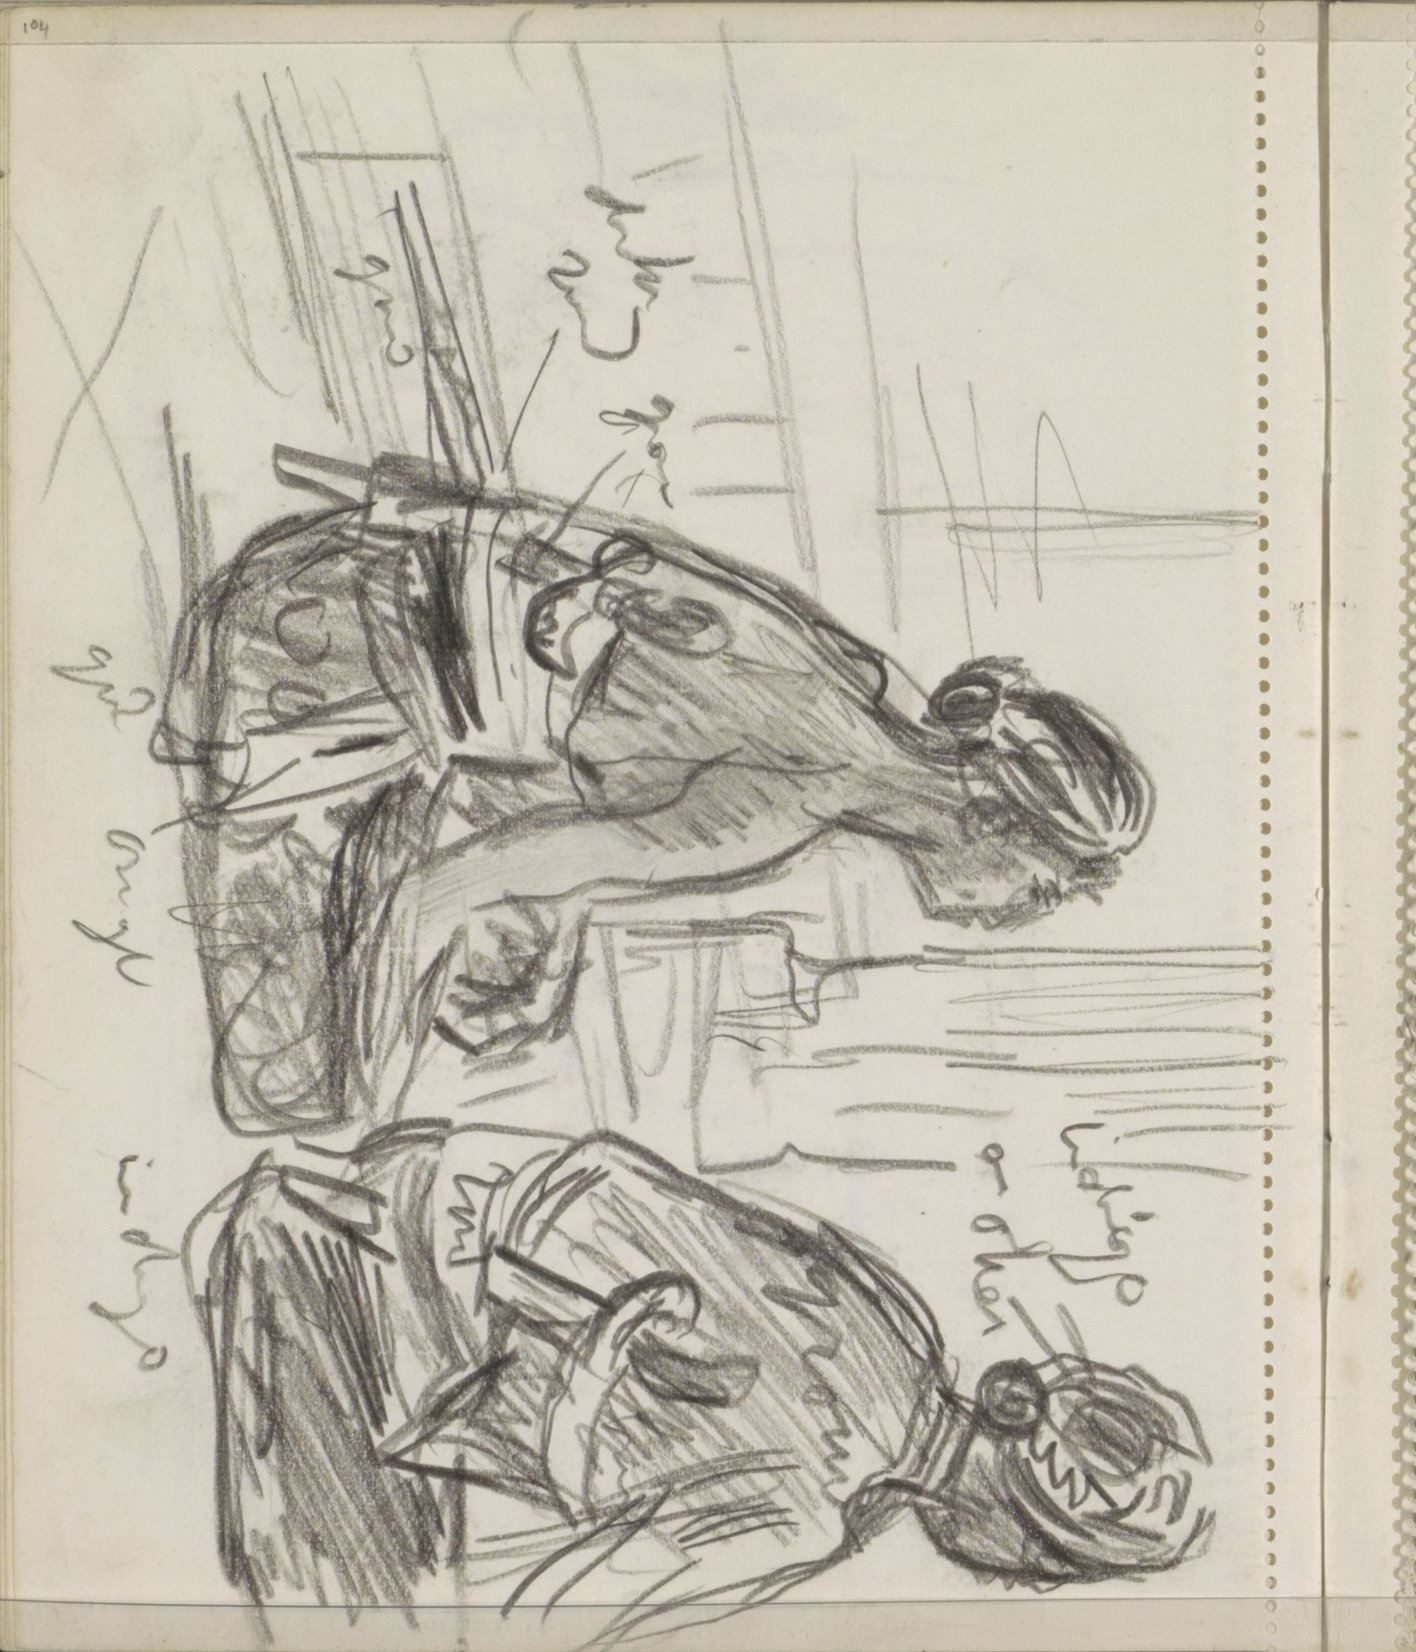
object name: sketchbook leaf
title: Twee zittende Indonesiërs in een interieur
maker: marius bauer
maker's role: draughtsman, print maker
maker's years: 1867-1932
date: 1925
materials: chalk, paper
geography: indonesia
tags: asiatic races and peoples, sitting figure, hacking and thrusting weapons: sword, folk costume, regional costume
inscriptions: kleurnotitie, handgeschreven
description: De figuren dragen traditioneel kostuum en hebben zwaarden in een doek om het middel gestoken. Pagina 104 uit een schetsboek met 67 bladen.